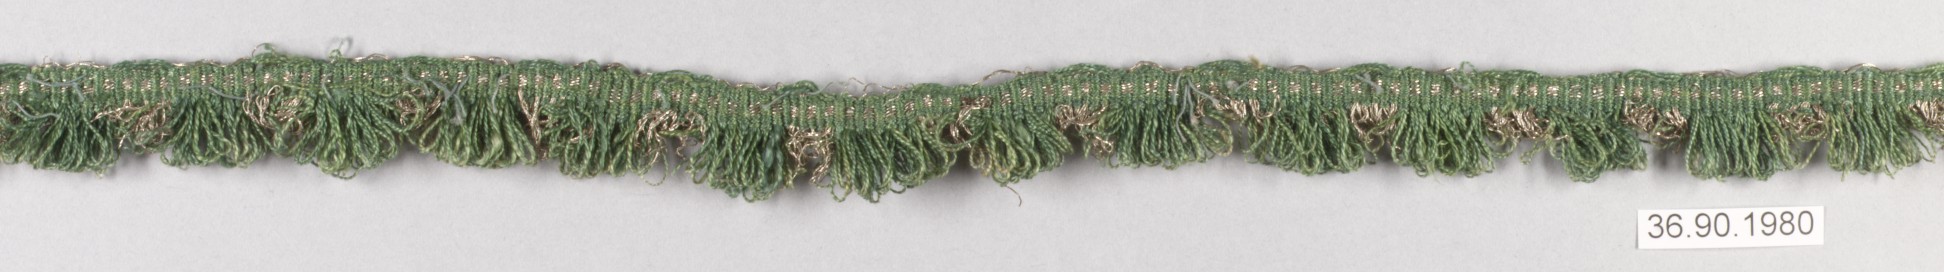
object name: fringe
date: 1750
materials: metal thread, silk